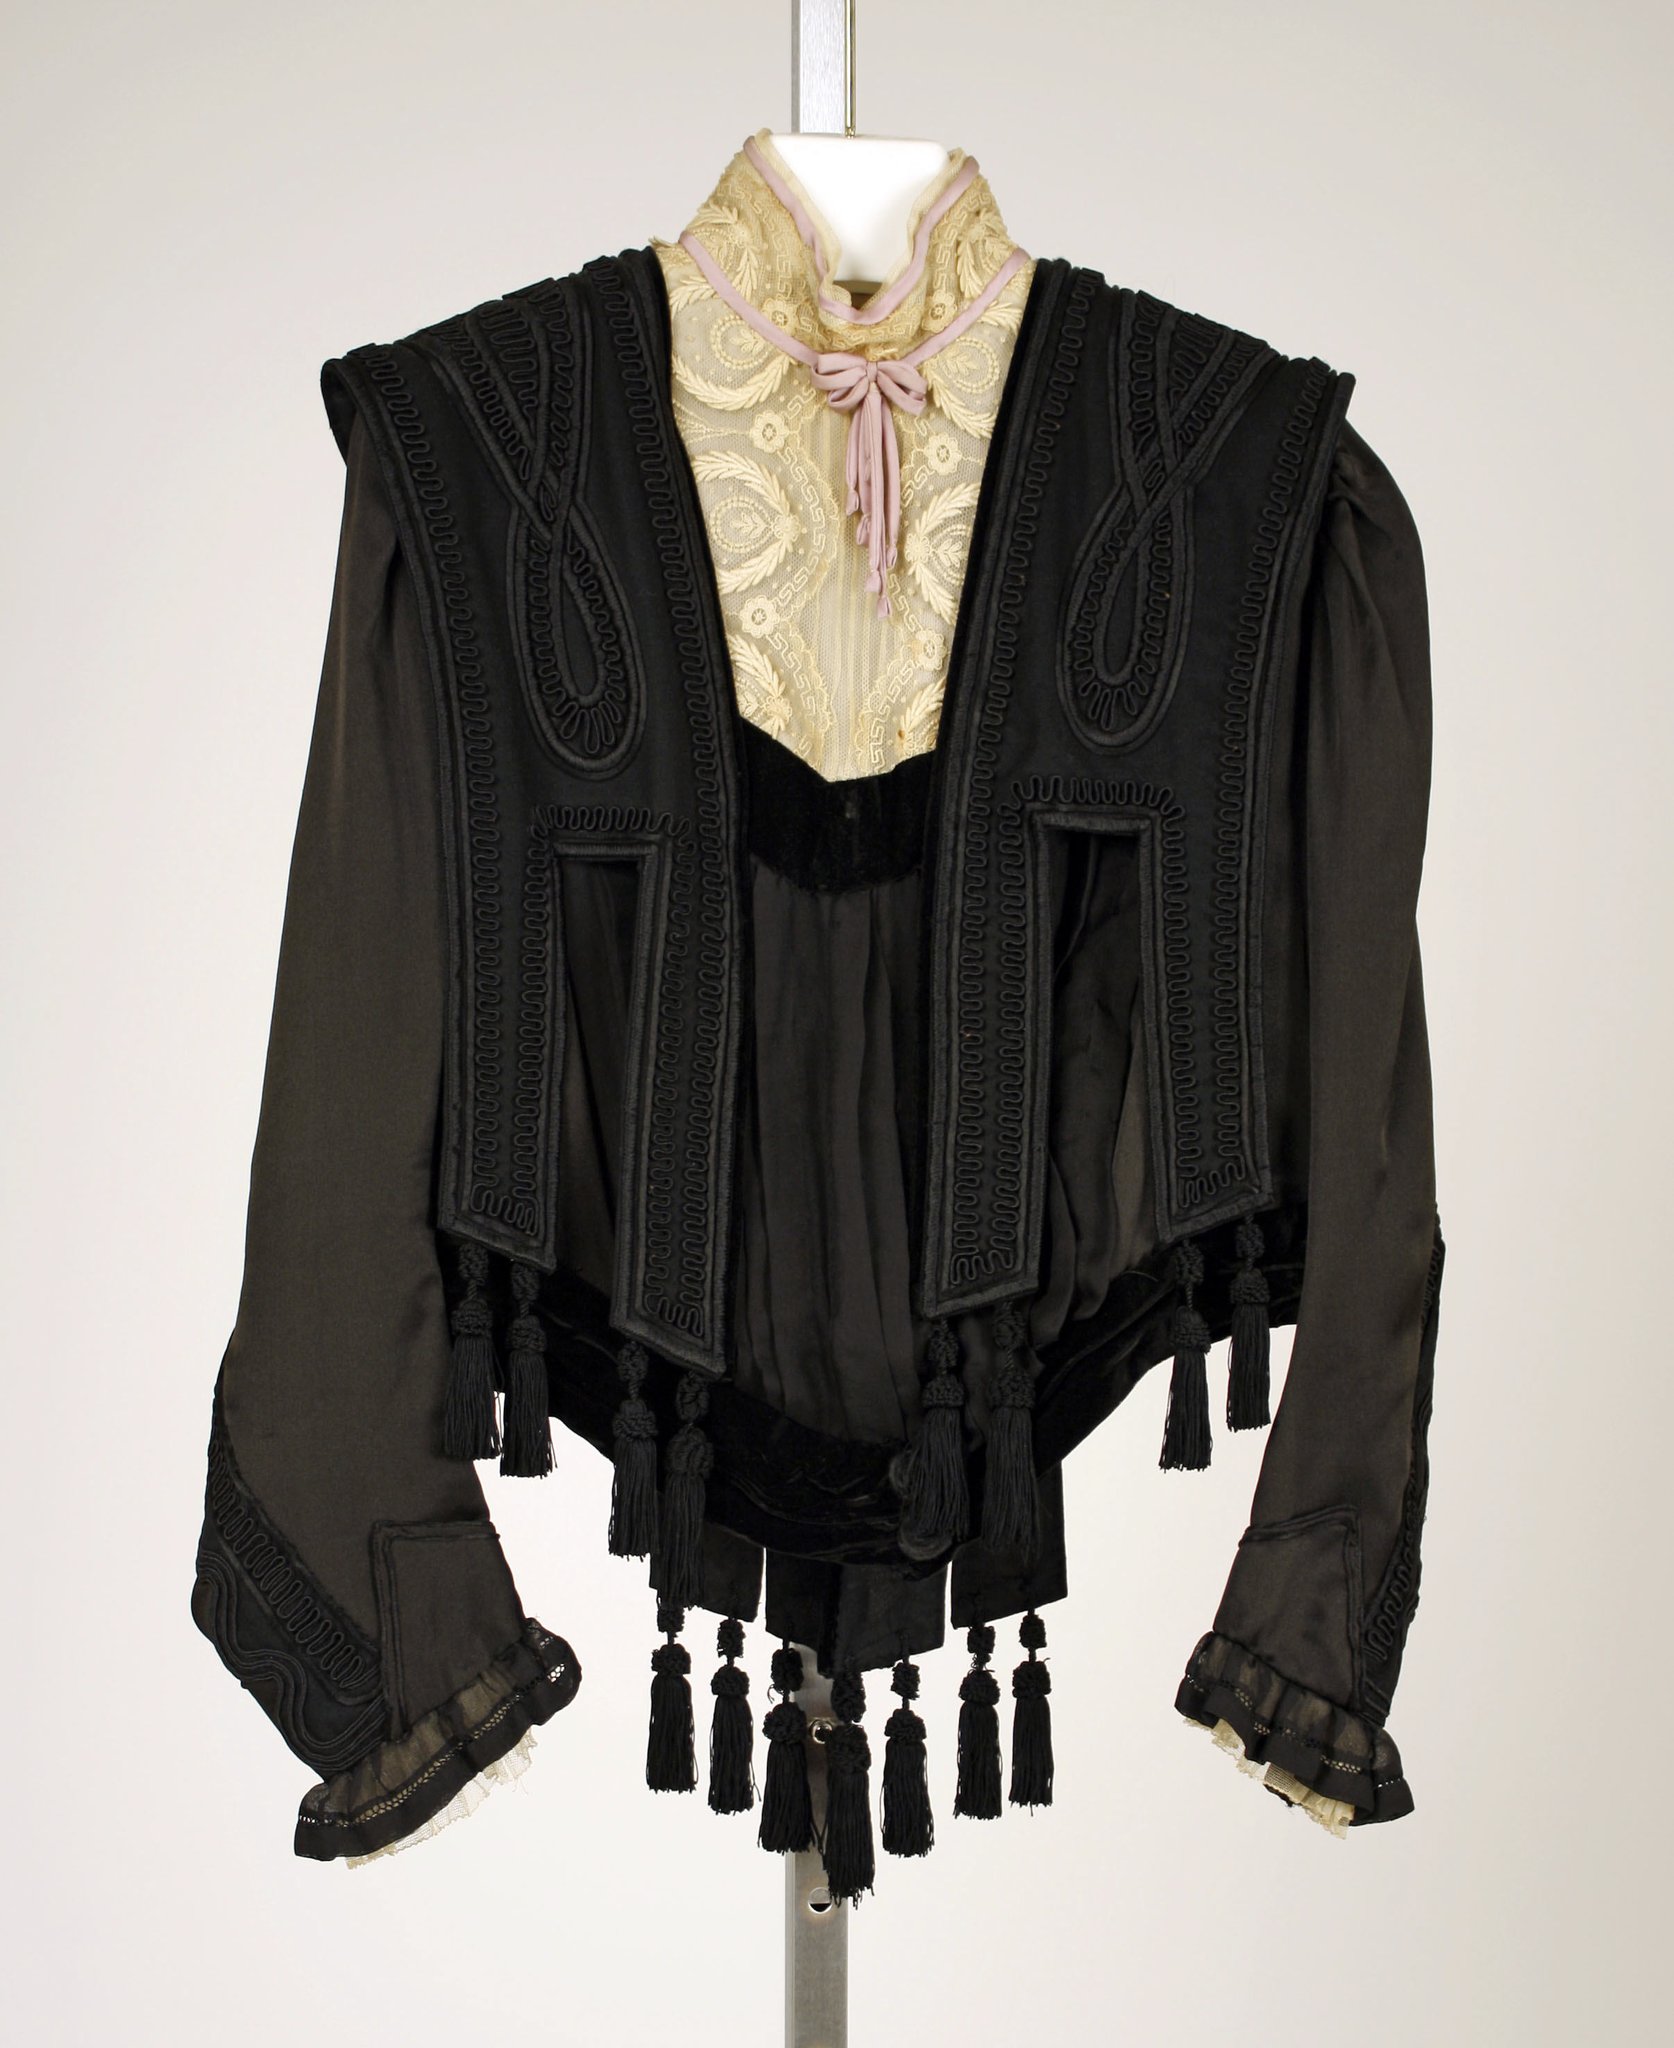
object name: suit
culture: french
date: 1902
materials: silk, wool